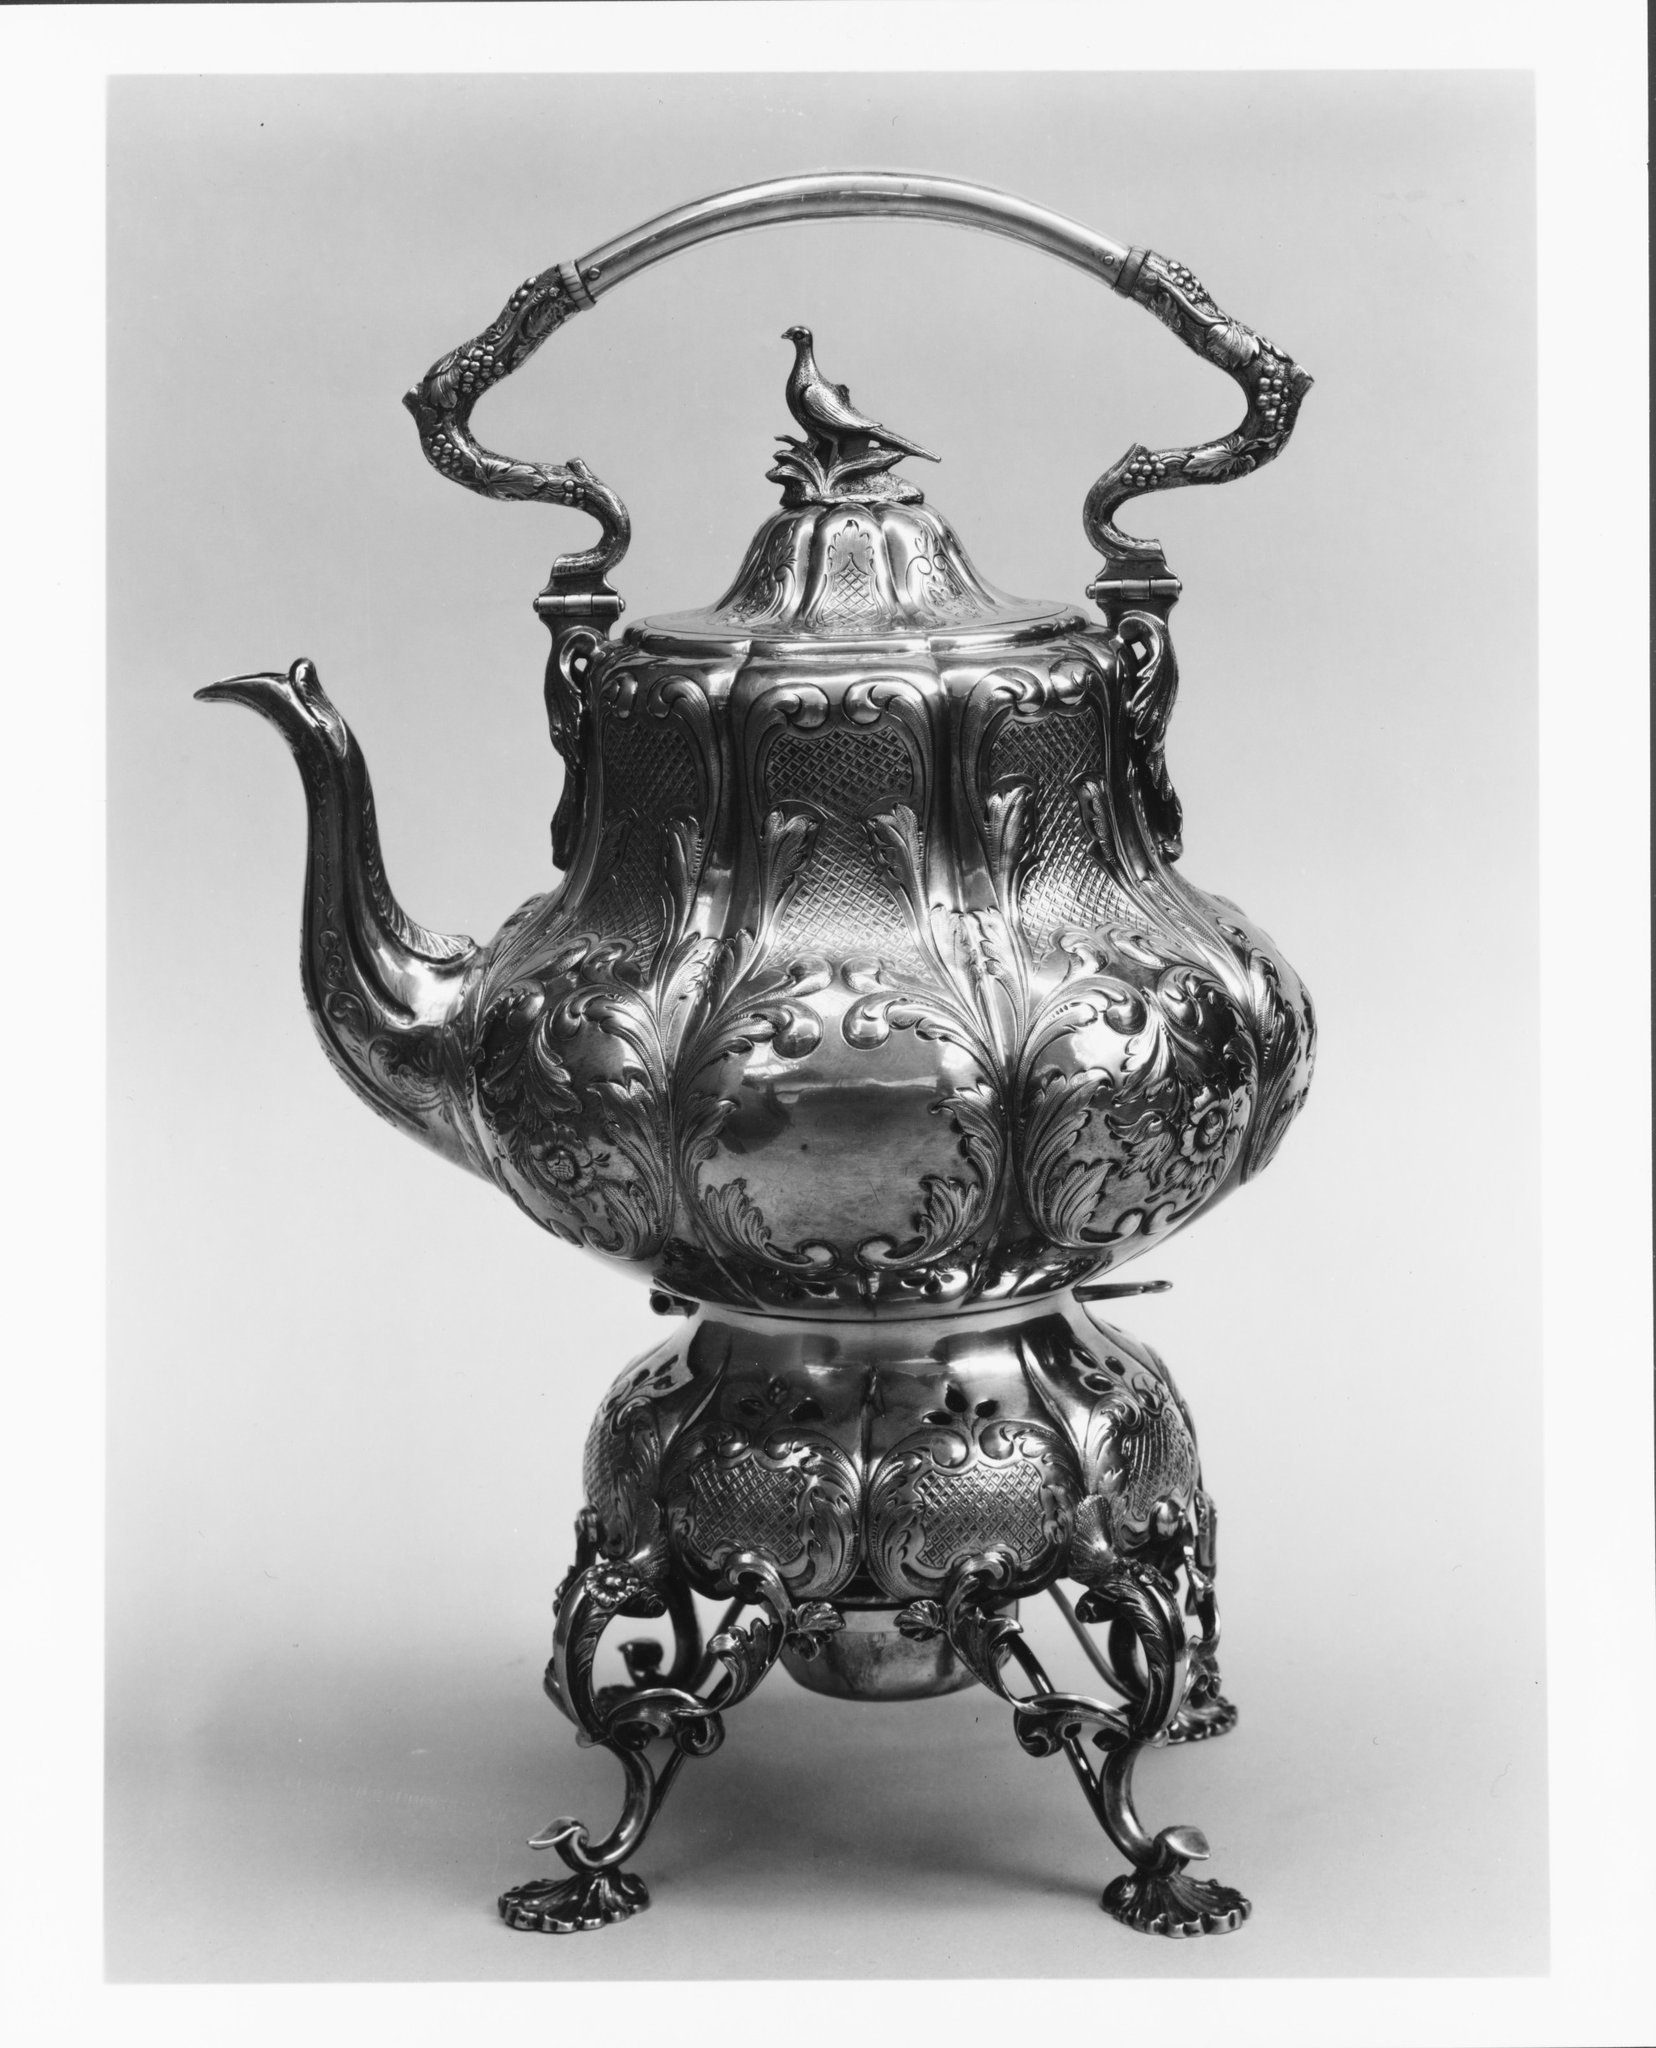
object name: teakettle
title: Teakettle, Burner, and Stand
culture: american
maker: ball, tompkins and black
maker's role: retailer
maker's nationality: american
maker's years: 1839-1851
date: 1848-1851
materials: ivory, silver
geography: united states